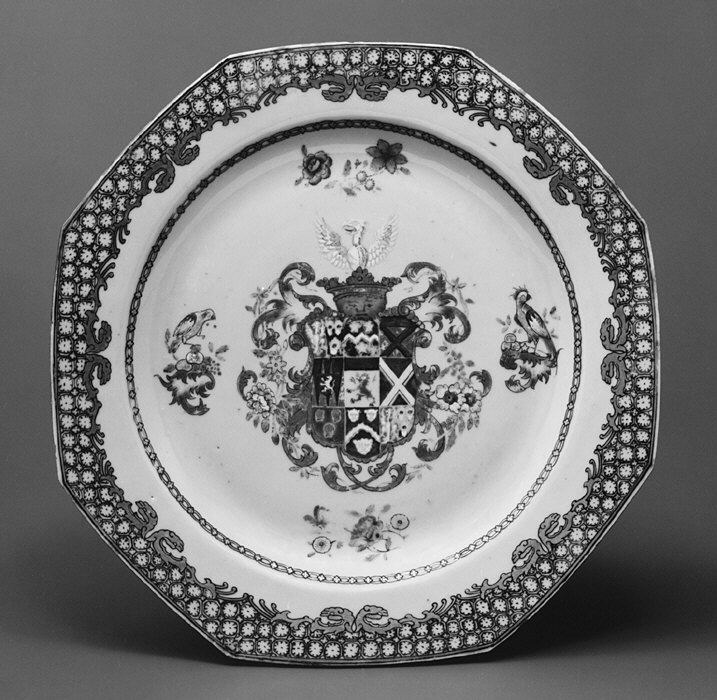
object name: plate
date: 1745-1755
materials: hard paste porcelain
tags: birds,coat of arms